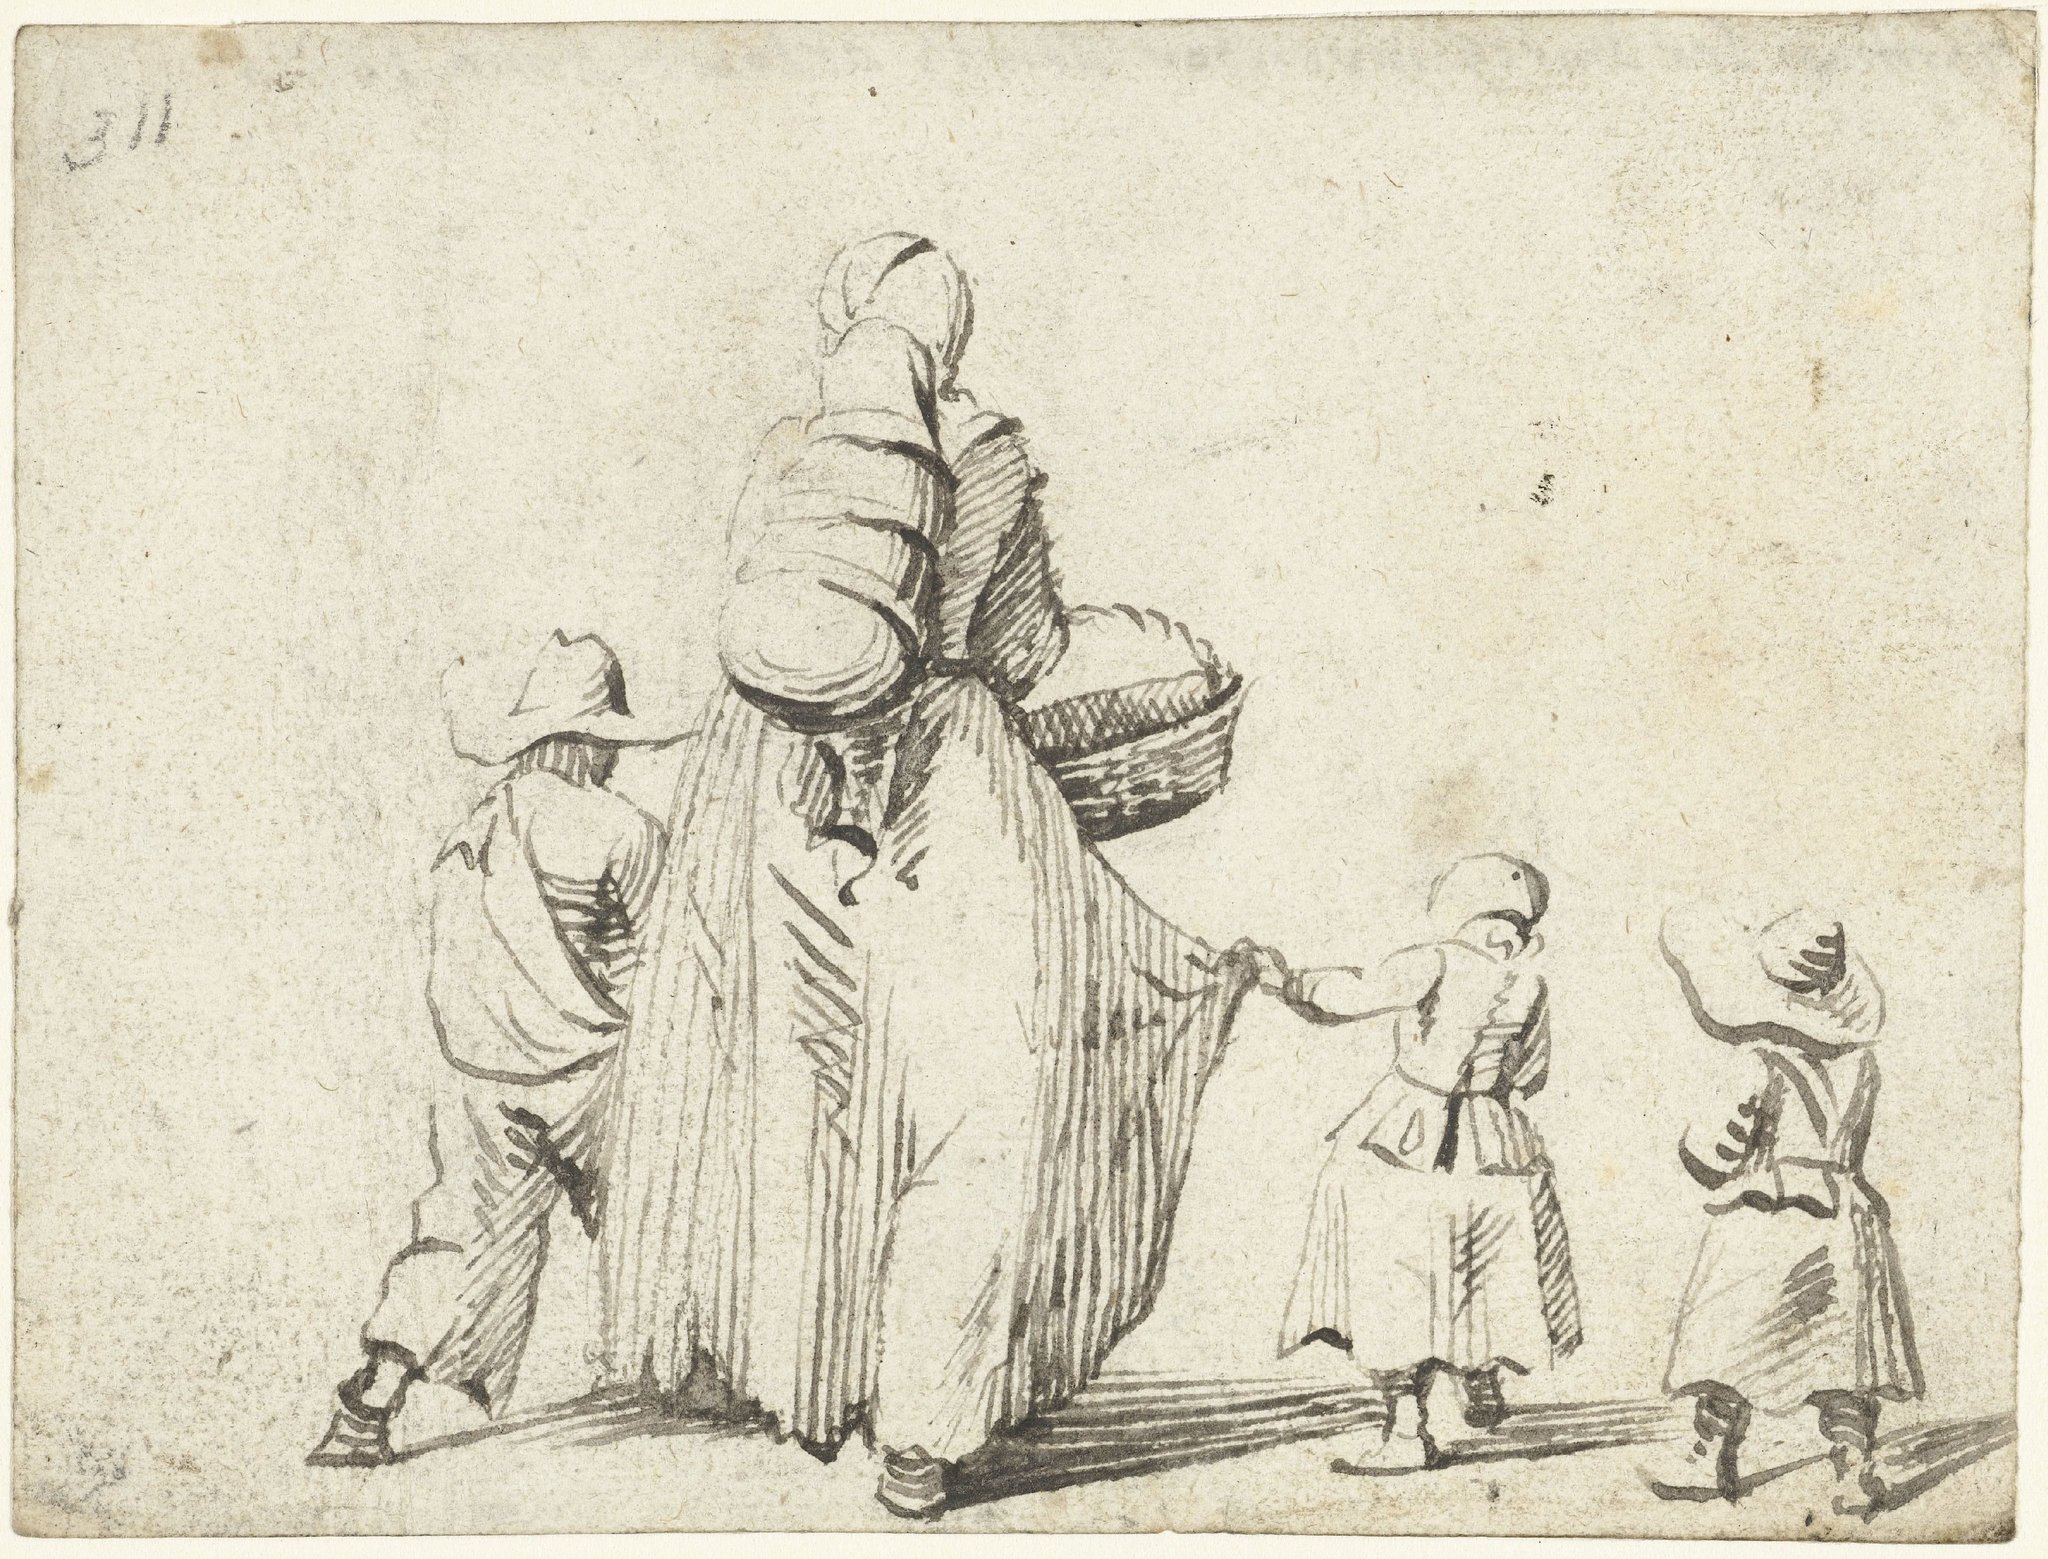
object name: drawing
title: Vrouw lopend met kinderen, van achteren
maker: harmen ter borch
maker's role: draughtsman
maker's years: 1638-1677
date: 1650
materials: ink, paper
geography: zwolle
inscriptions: annotation: ‘Harman ter Borch. inventor. den 19.october Anno 1650’